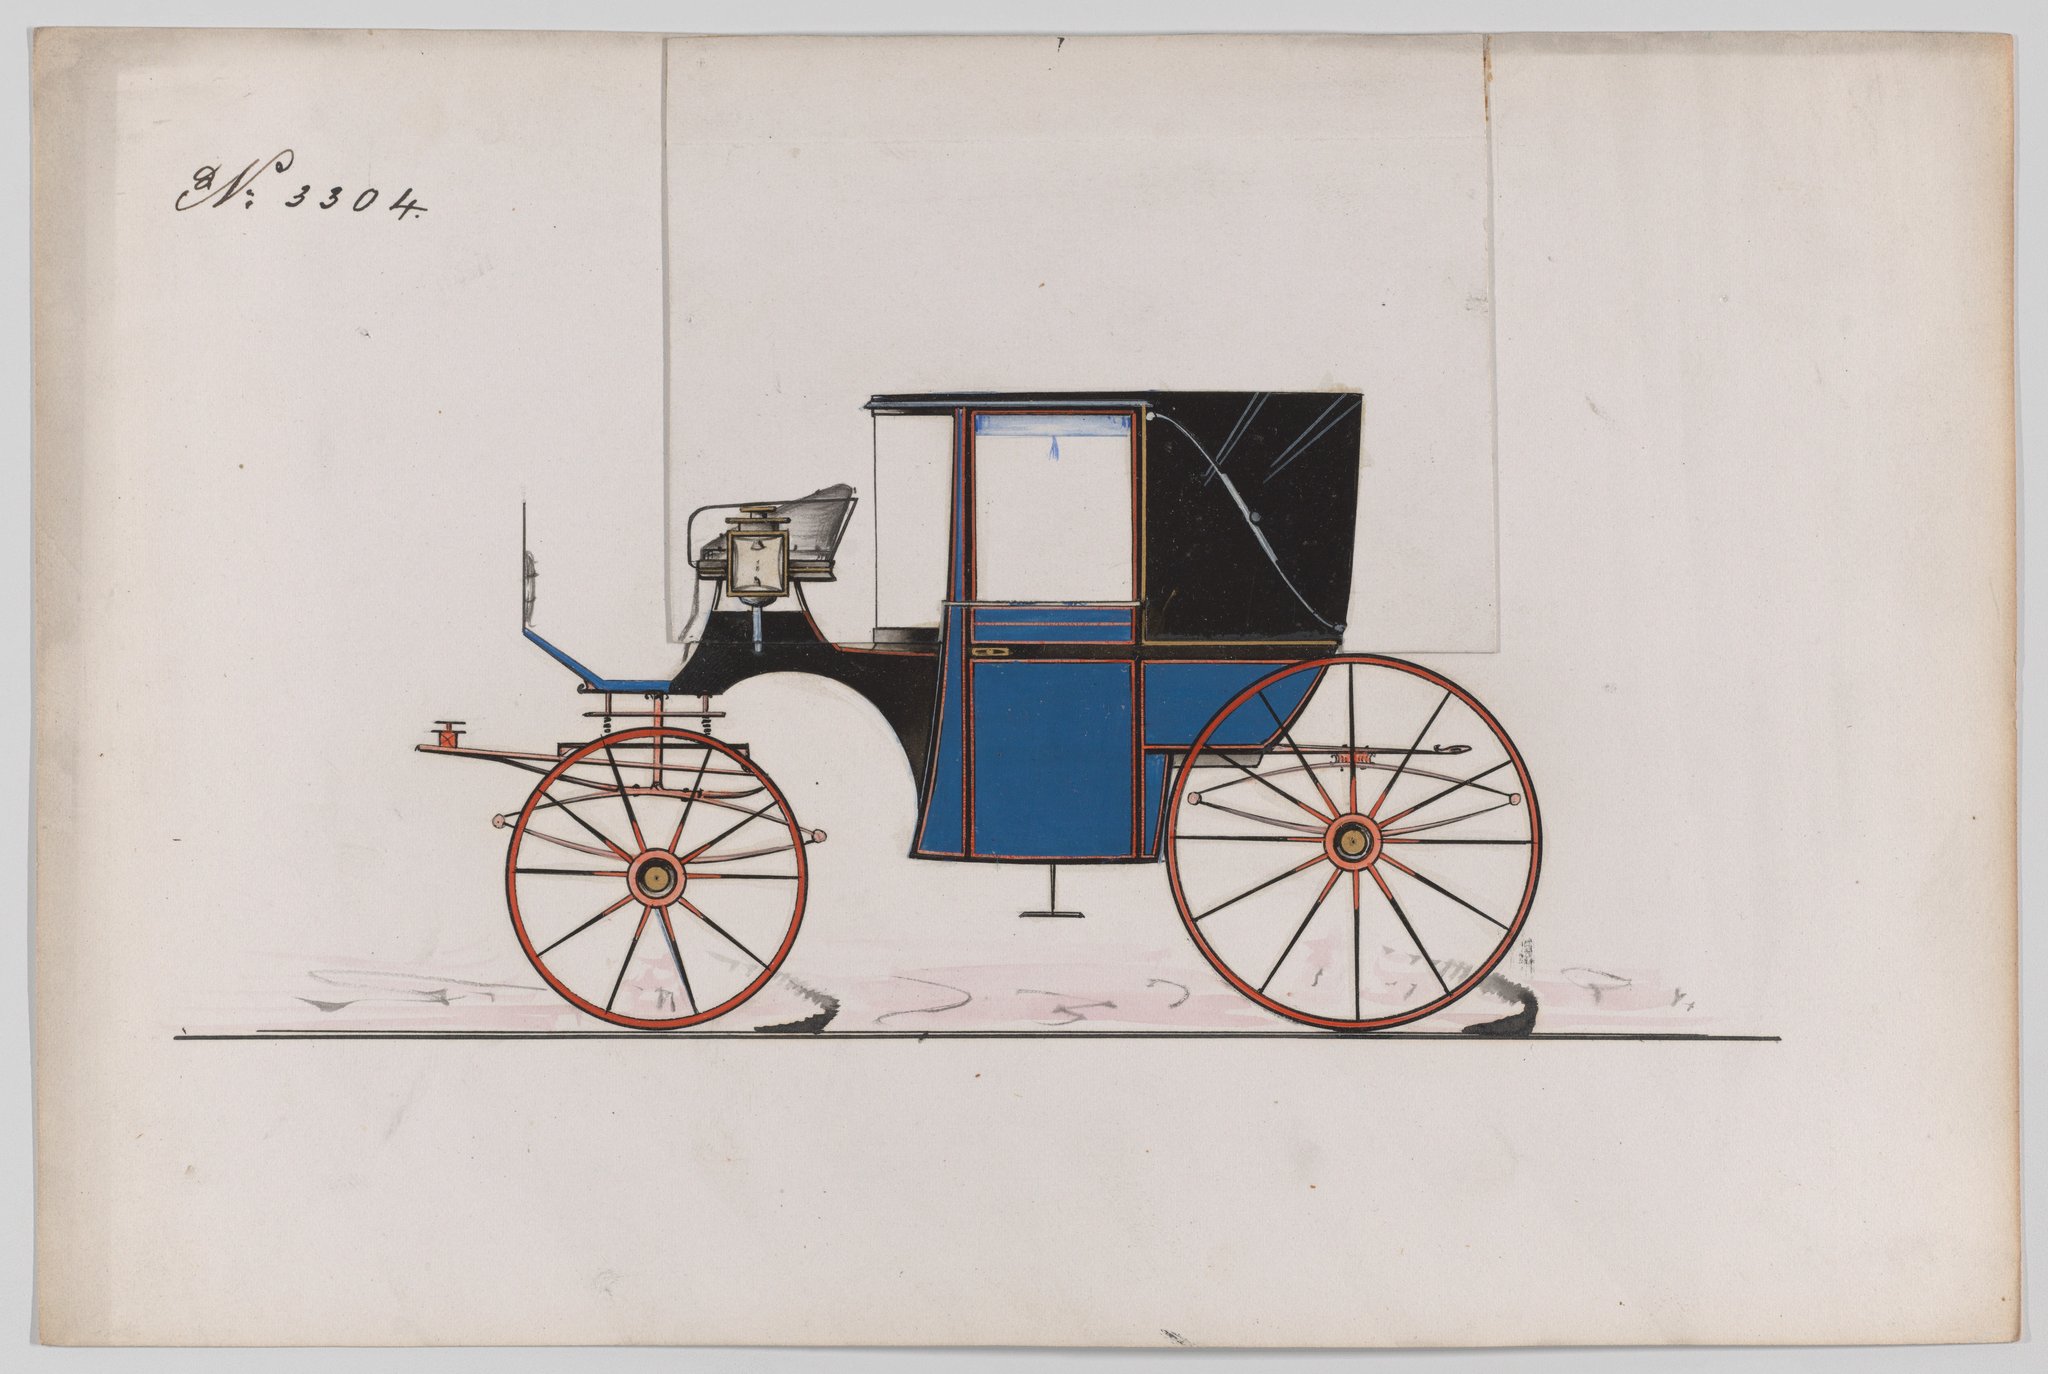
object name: drawing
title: Design for Landaulet, no. 3304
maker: brewster & co.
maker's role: manufacturer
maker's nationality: american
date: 1877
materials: gouache, gum arabic, ink, watercolor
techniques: pen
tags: carriages